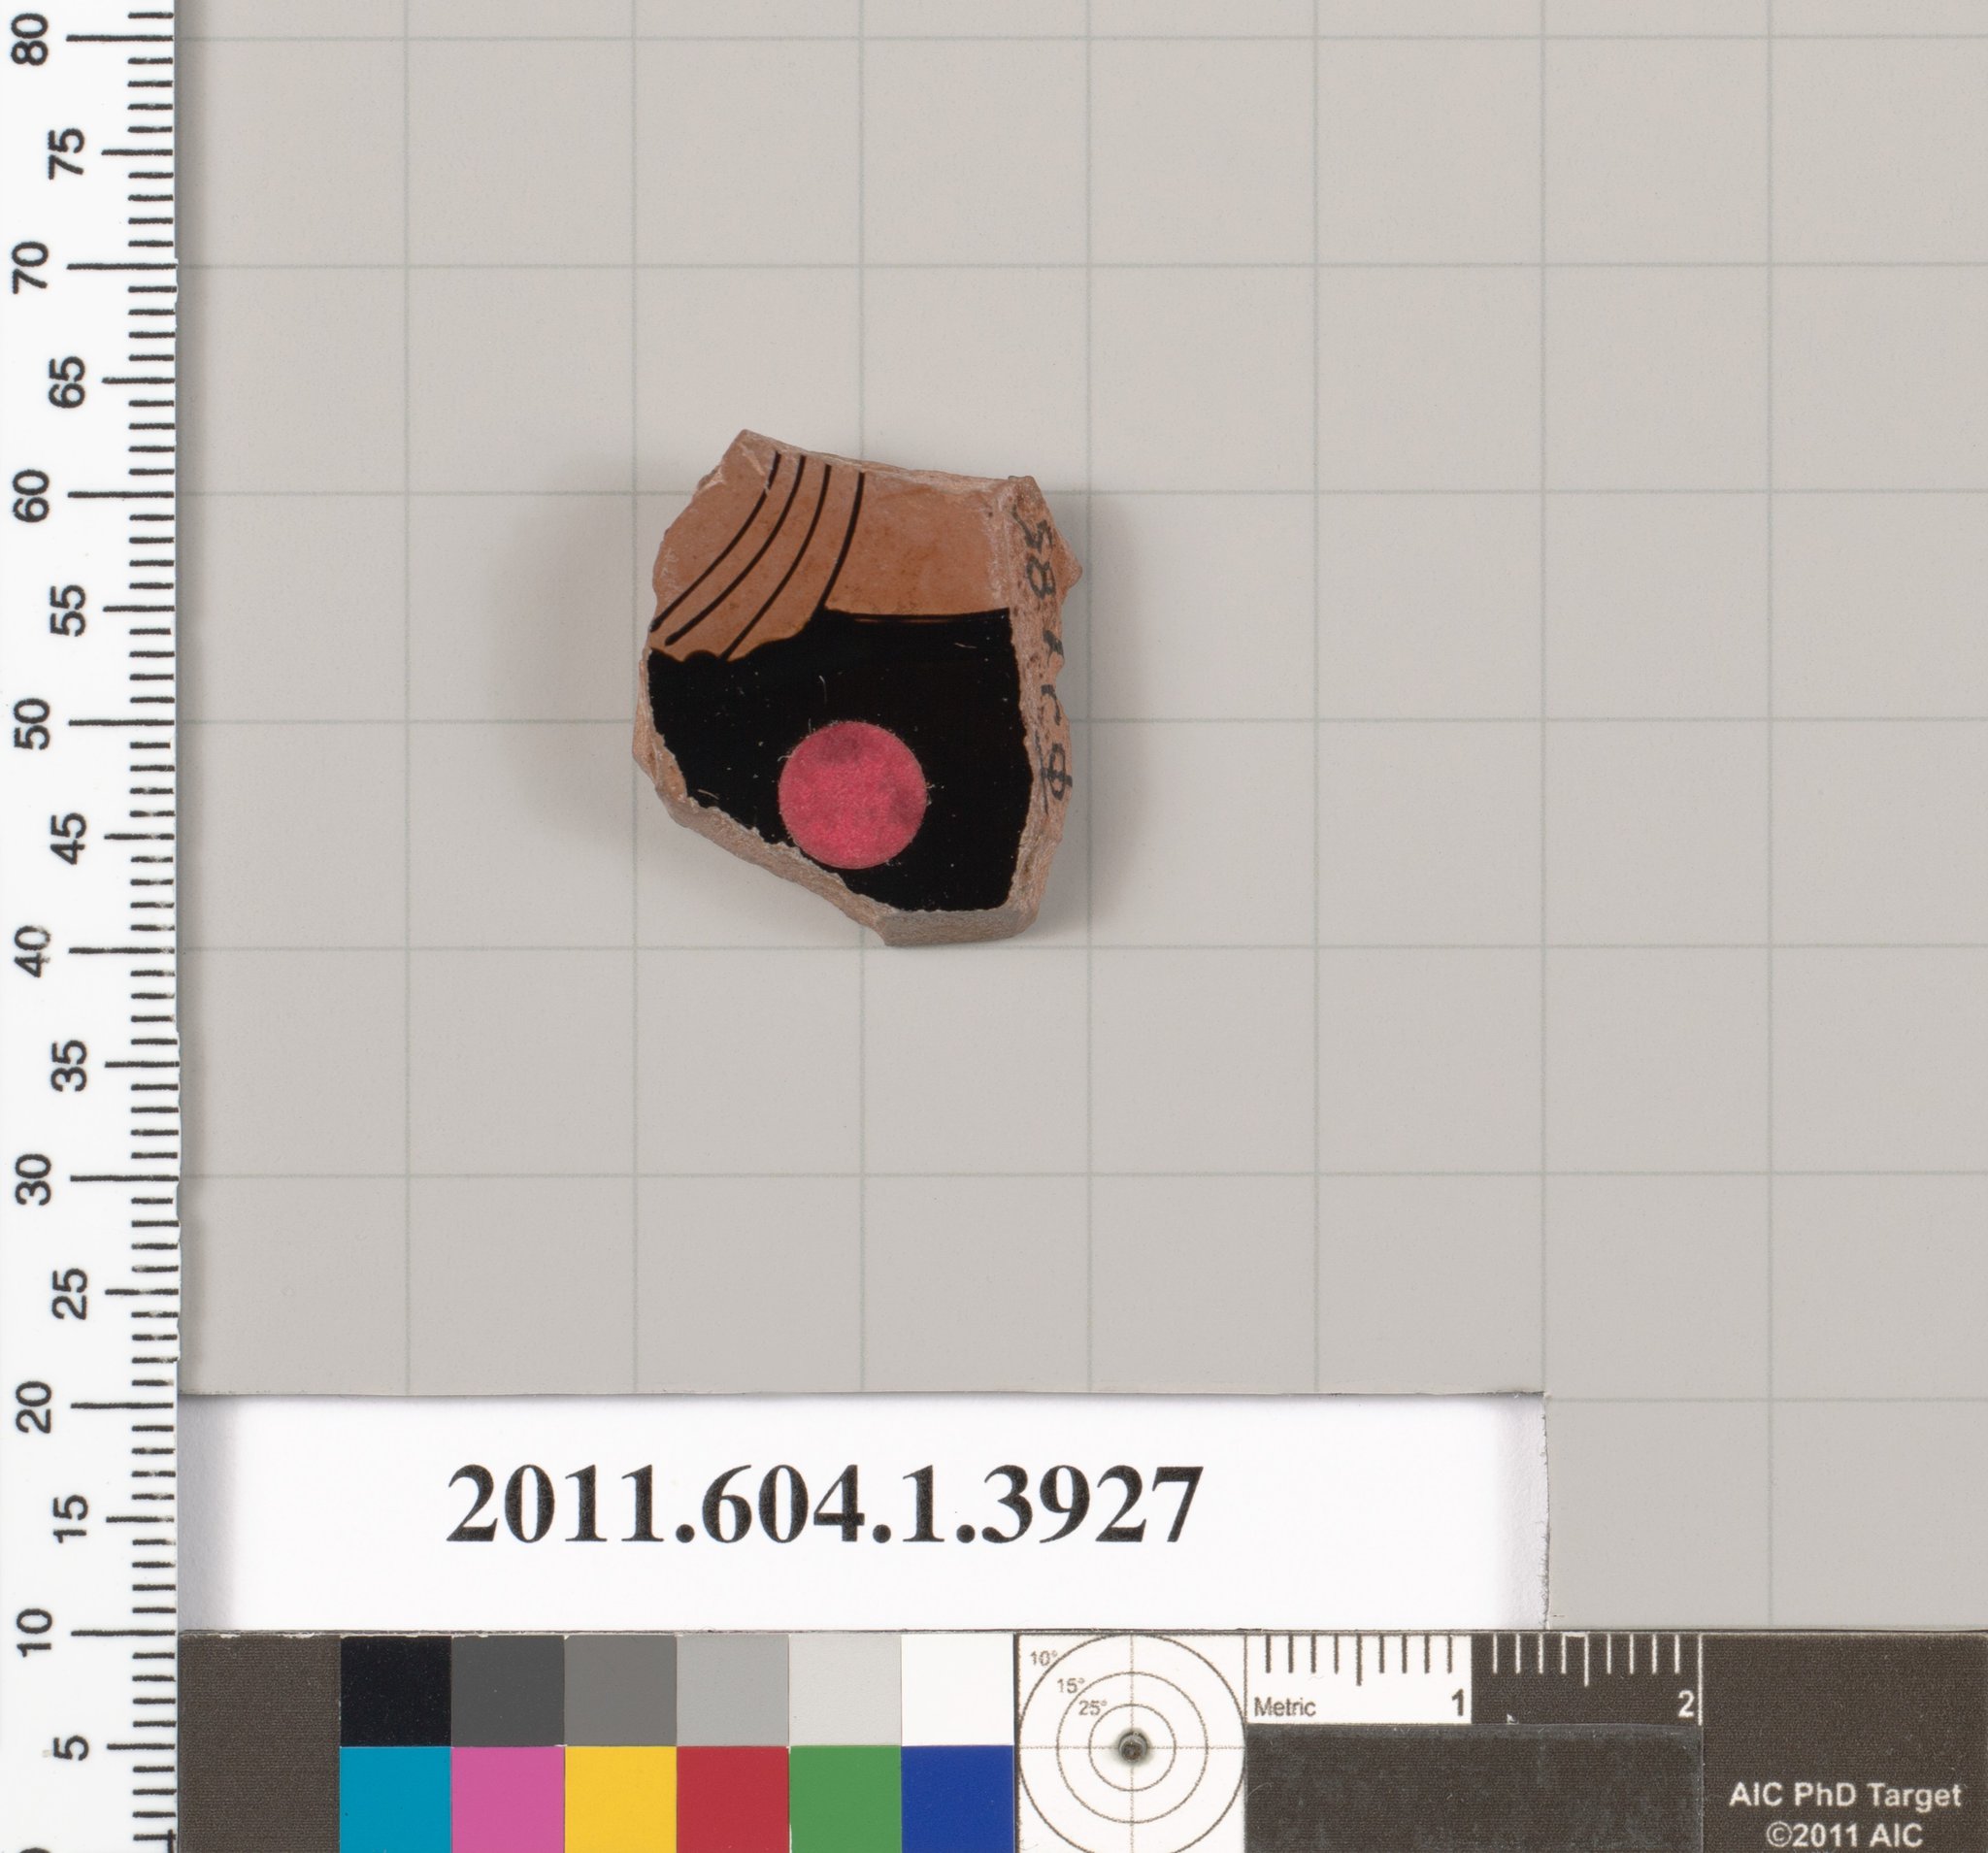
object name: kylix fragment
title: Terracotta fragment of a kylix (drinking cup)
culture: greek, attic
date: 510-490 BCE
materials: terracotta